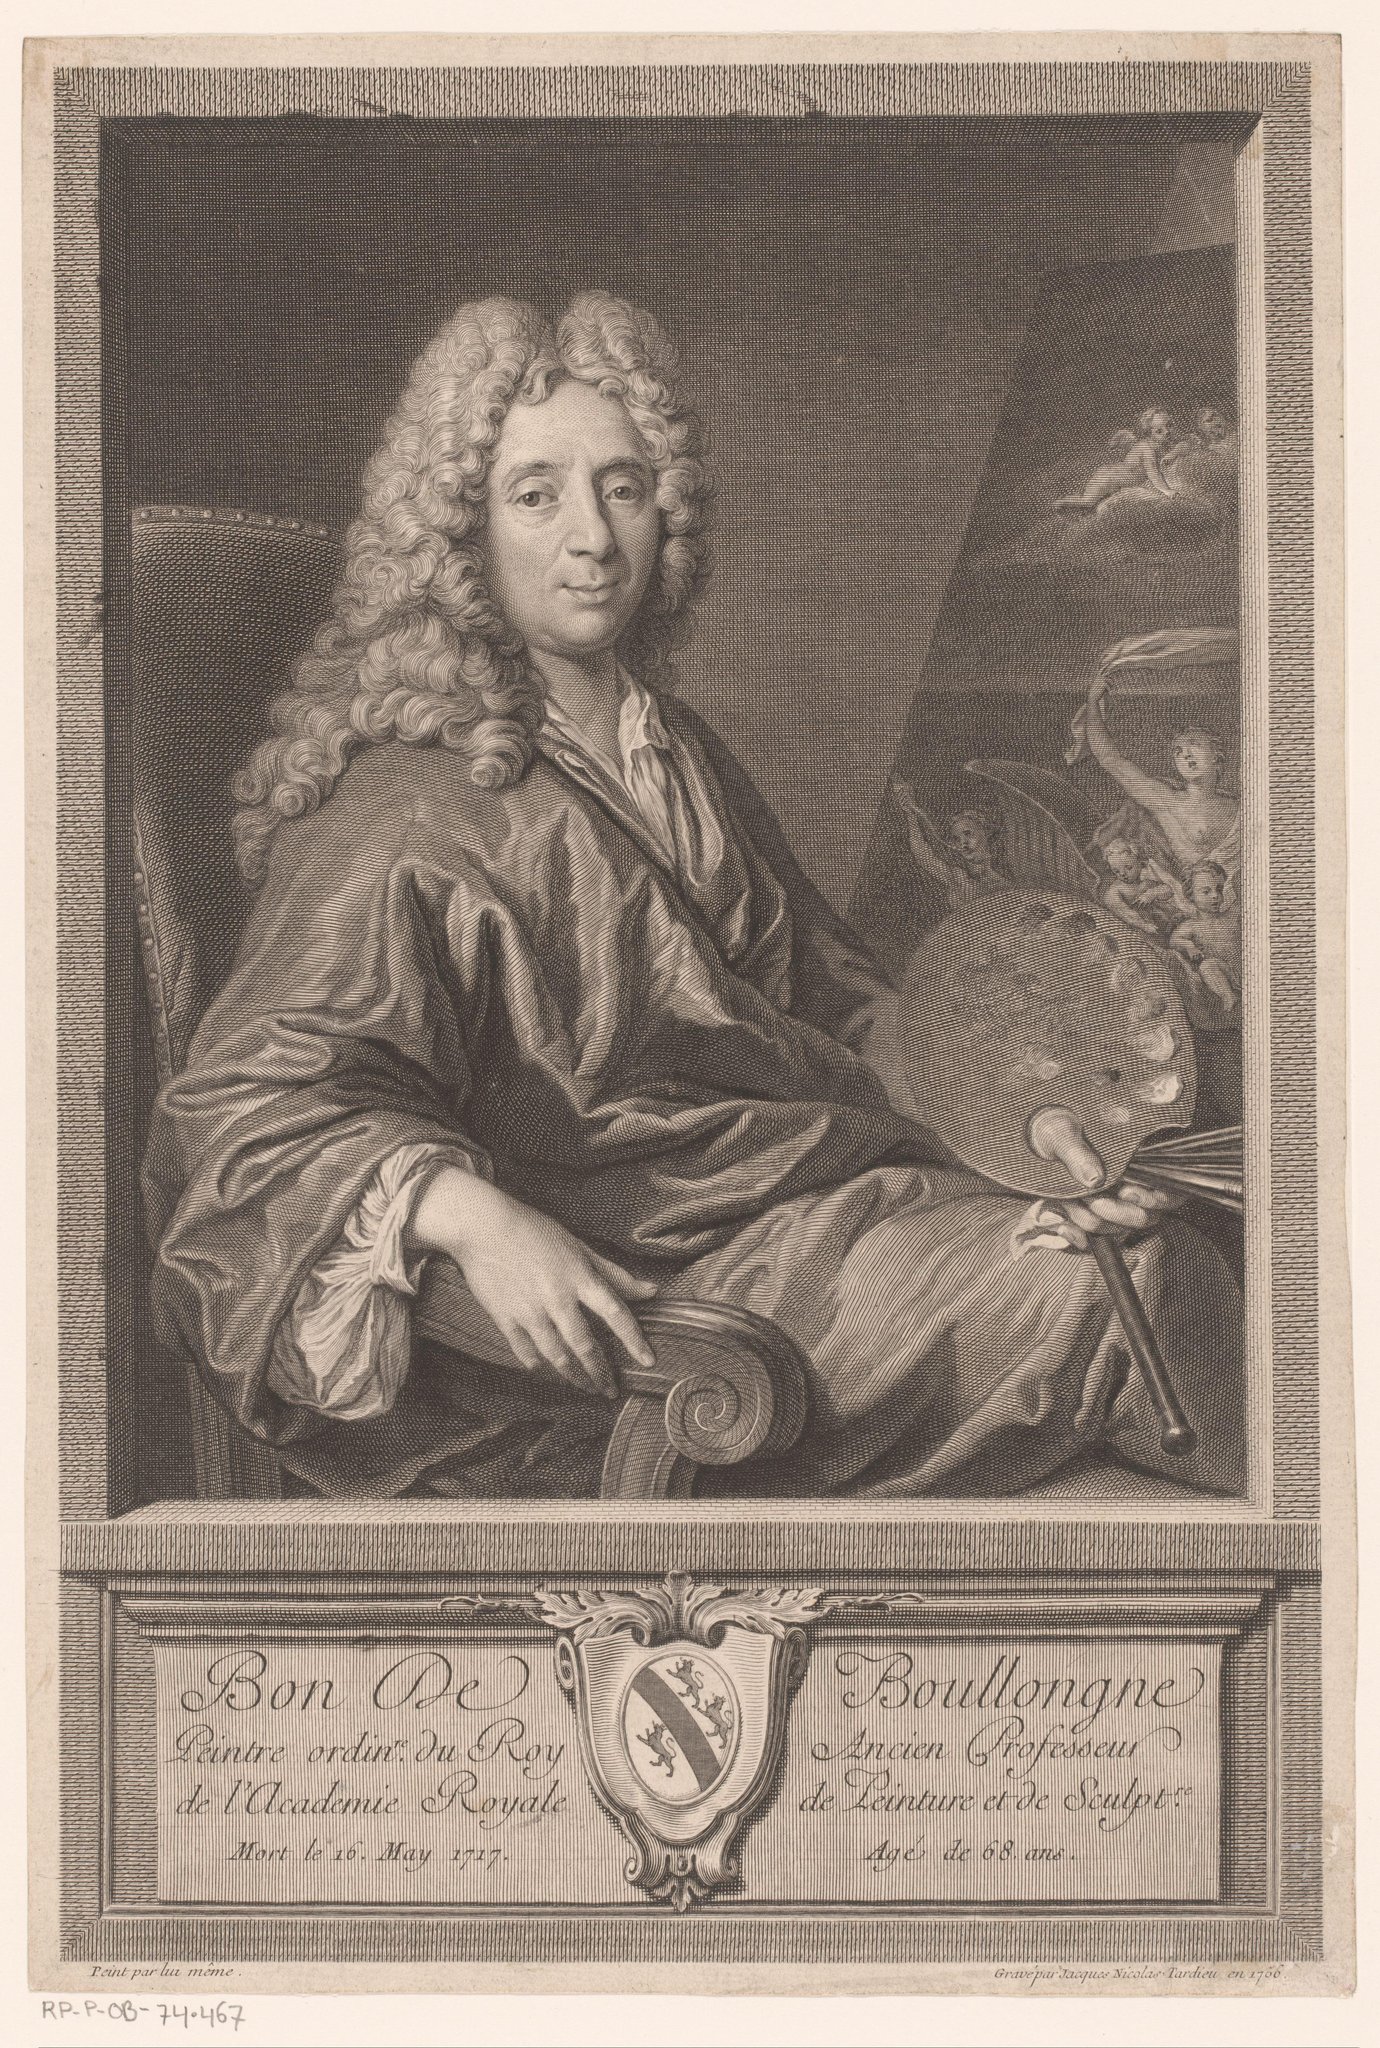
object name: print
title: Portret van Bon Boullogne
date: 1756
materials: paper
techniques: engraving, etching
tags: paris, print maker, bon boullogne, historical persons, portrait, self-portrait of painter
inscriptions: collector's mark: Lugt 1413, collector's mark: Lugt 2228